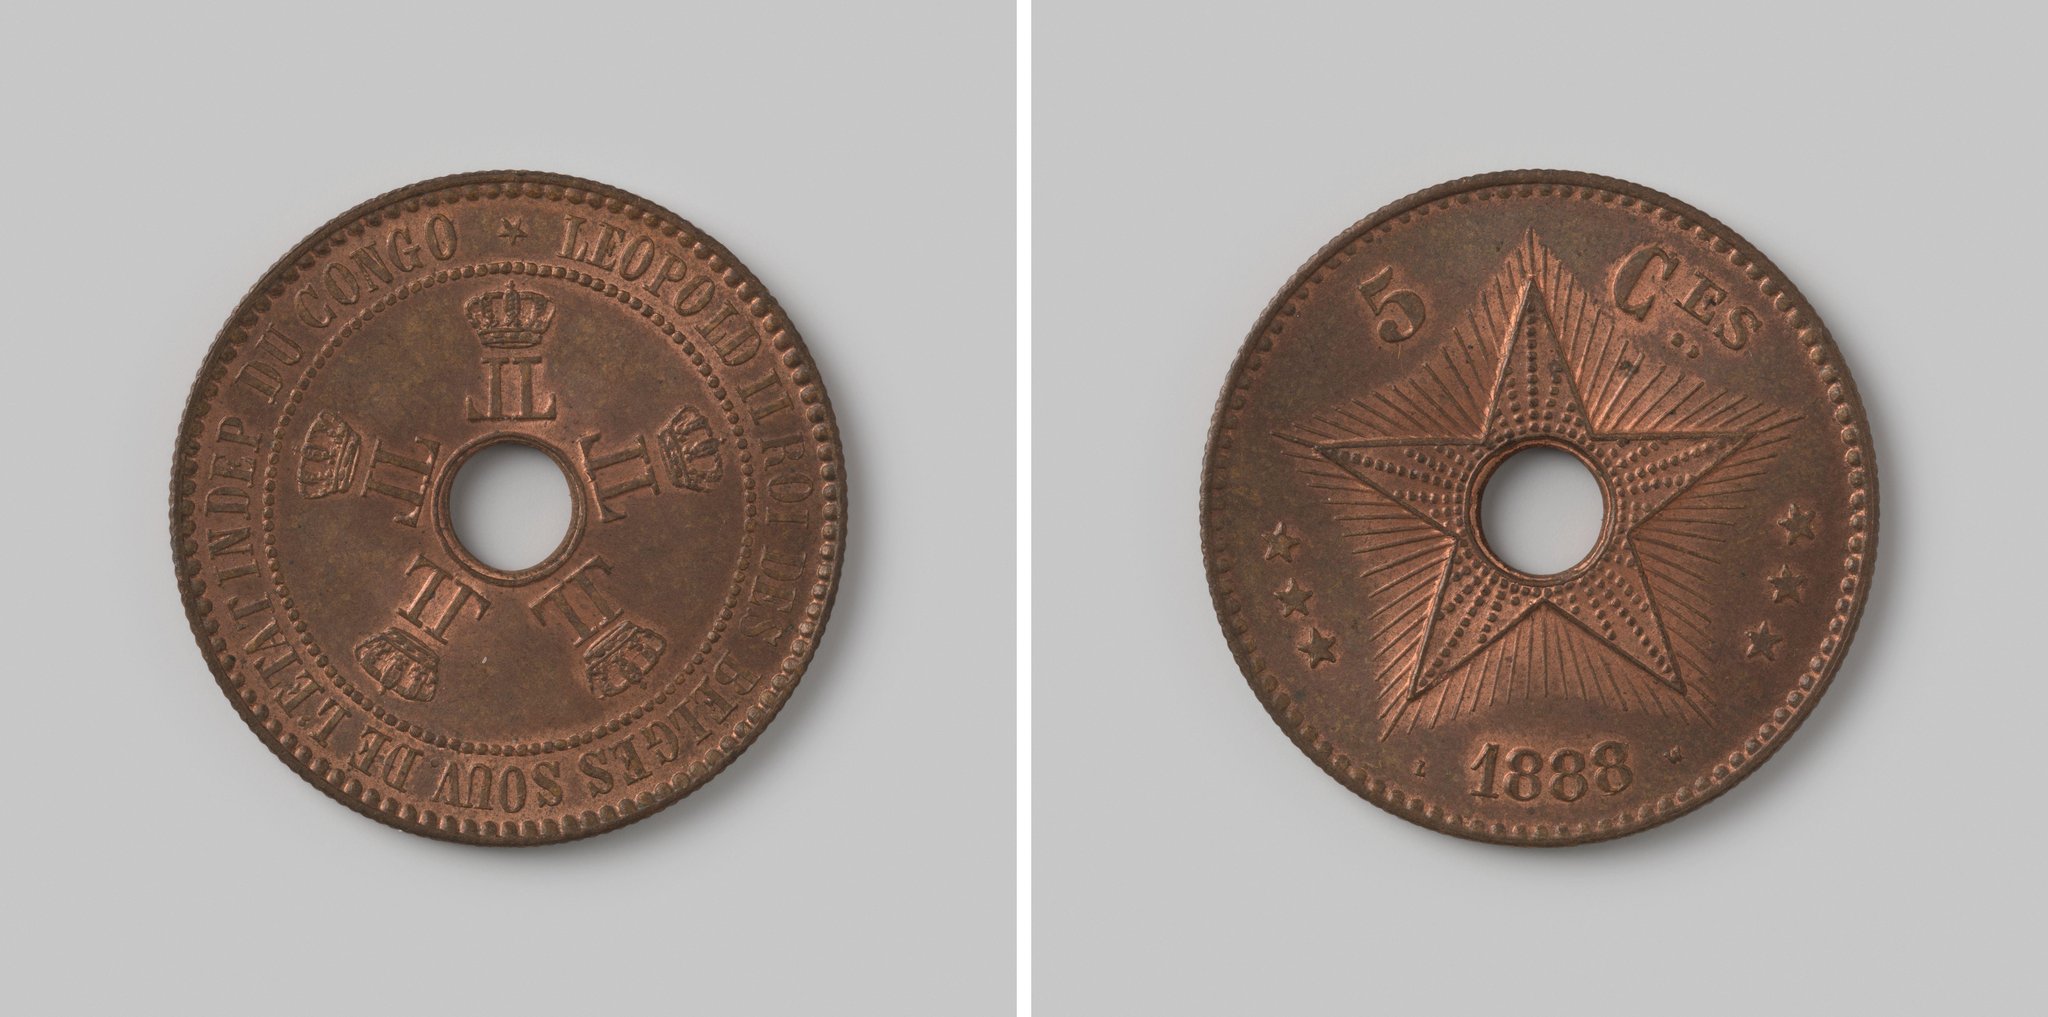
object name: coin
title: Congo Vrijstaat, koning Leopold II van België als soeverein, 5 centimes, 1888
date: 1888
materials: copper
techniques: striking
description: Koperen munt met centrale doorboring. Voorzijde: rondom centrale doorboring vijf, in vijfpuntige stervorm geplaatste dubbele, ten opzichte van elkaar gespiegelde, letters L, waarboven een kroon [= koning Leopold II]. Keerzijde: rondom centrale doorboring vijfpuntige ster, waaruit stralen. In omschrift waarde-aanduiding: 5 Ces.. en jaartal. Kartelrand.